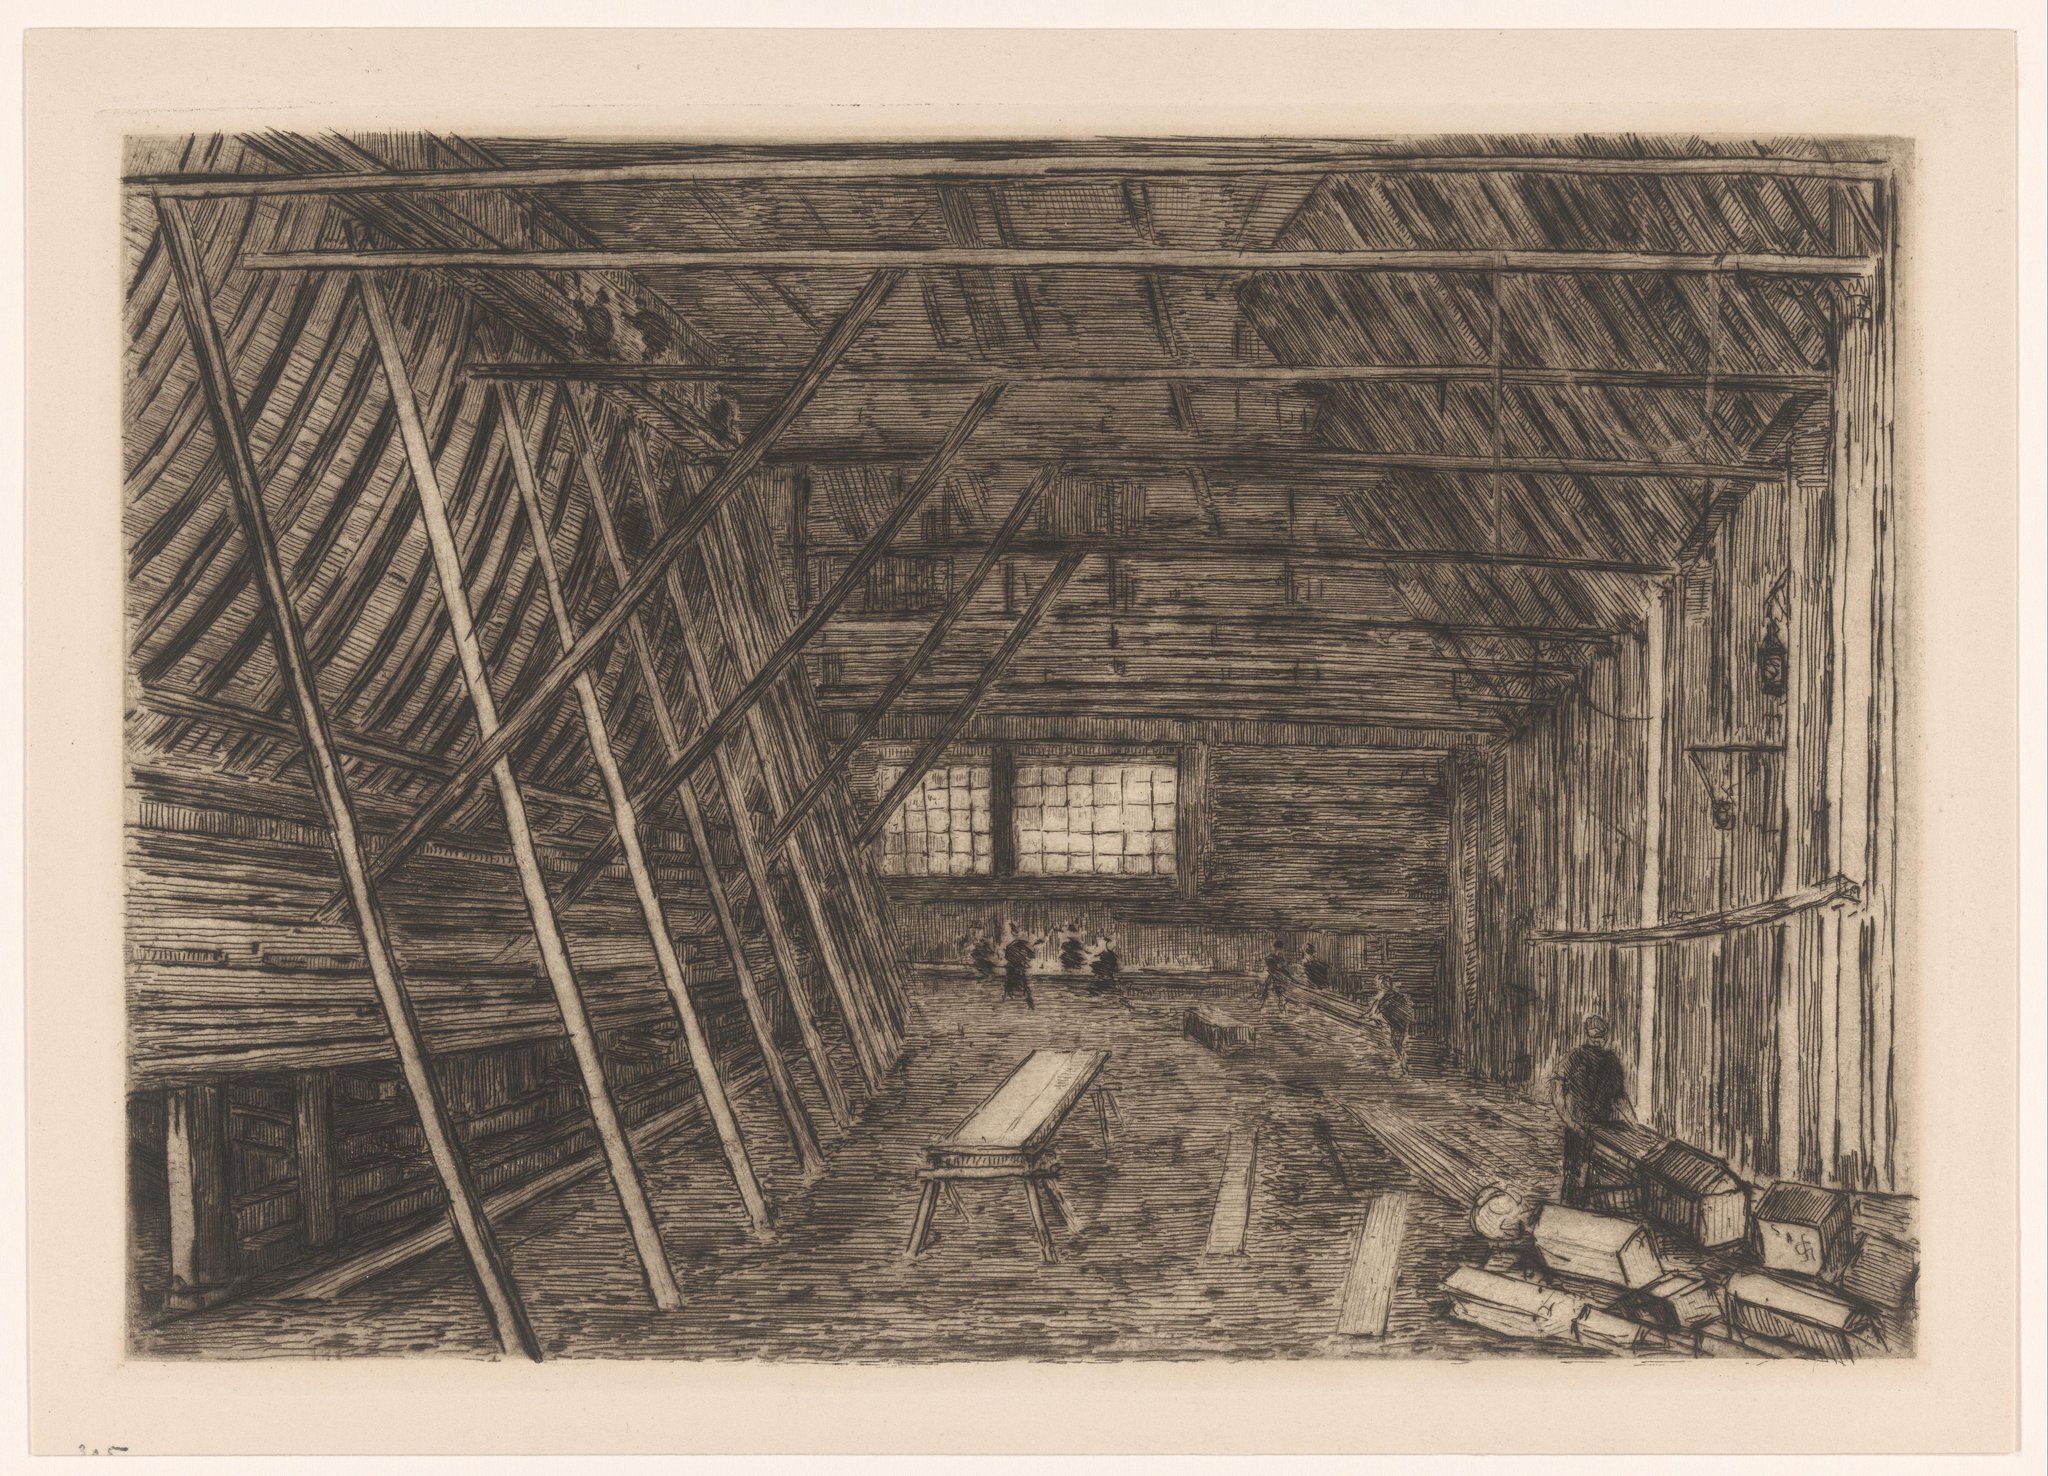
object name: print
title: Werkplaats in een werf in Vlissingen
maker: carel nicolaas storm van s-gravesande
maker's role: draughtsman, print maker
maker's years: 1841-1924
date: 1851-1902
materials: paper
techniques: drypoint, etching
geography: netherlands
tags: pier, quay, wharf, workshop-interior, flushing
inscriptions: number: ‘305’, collector's mark: Lugt 2228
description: Mogelijk vermeld in: Storm van 's-Gravesande, Charles. Catalogue des eaux-fortes et lithographies. New York: s.n., 1903, of in een onbekende latere uitgave van het manuscript. Vermoedelijk vermeld als catalogusnummer 305.